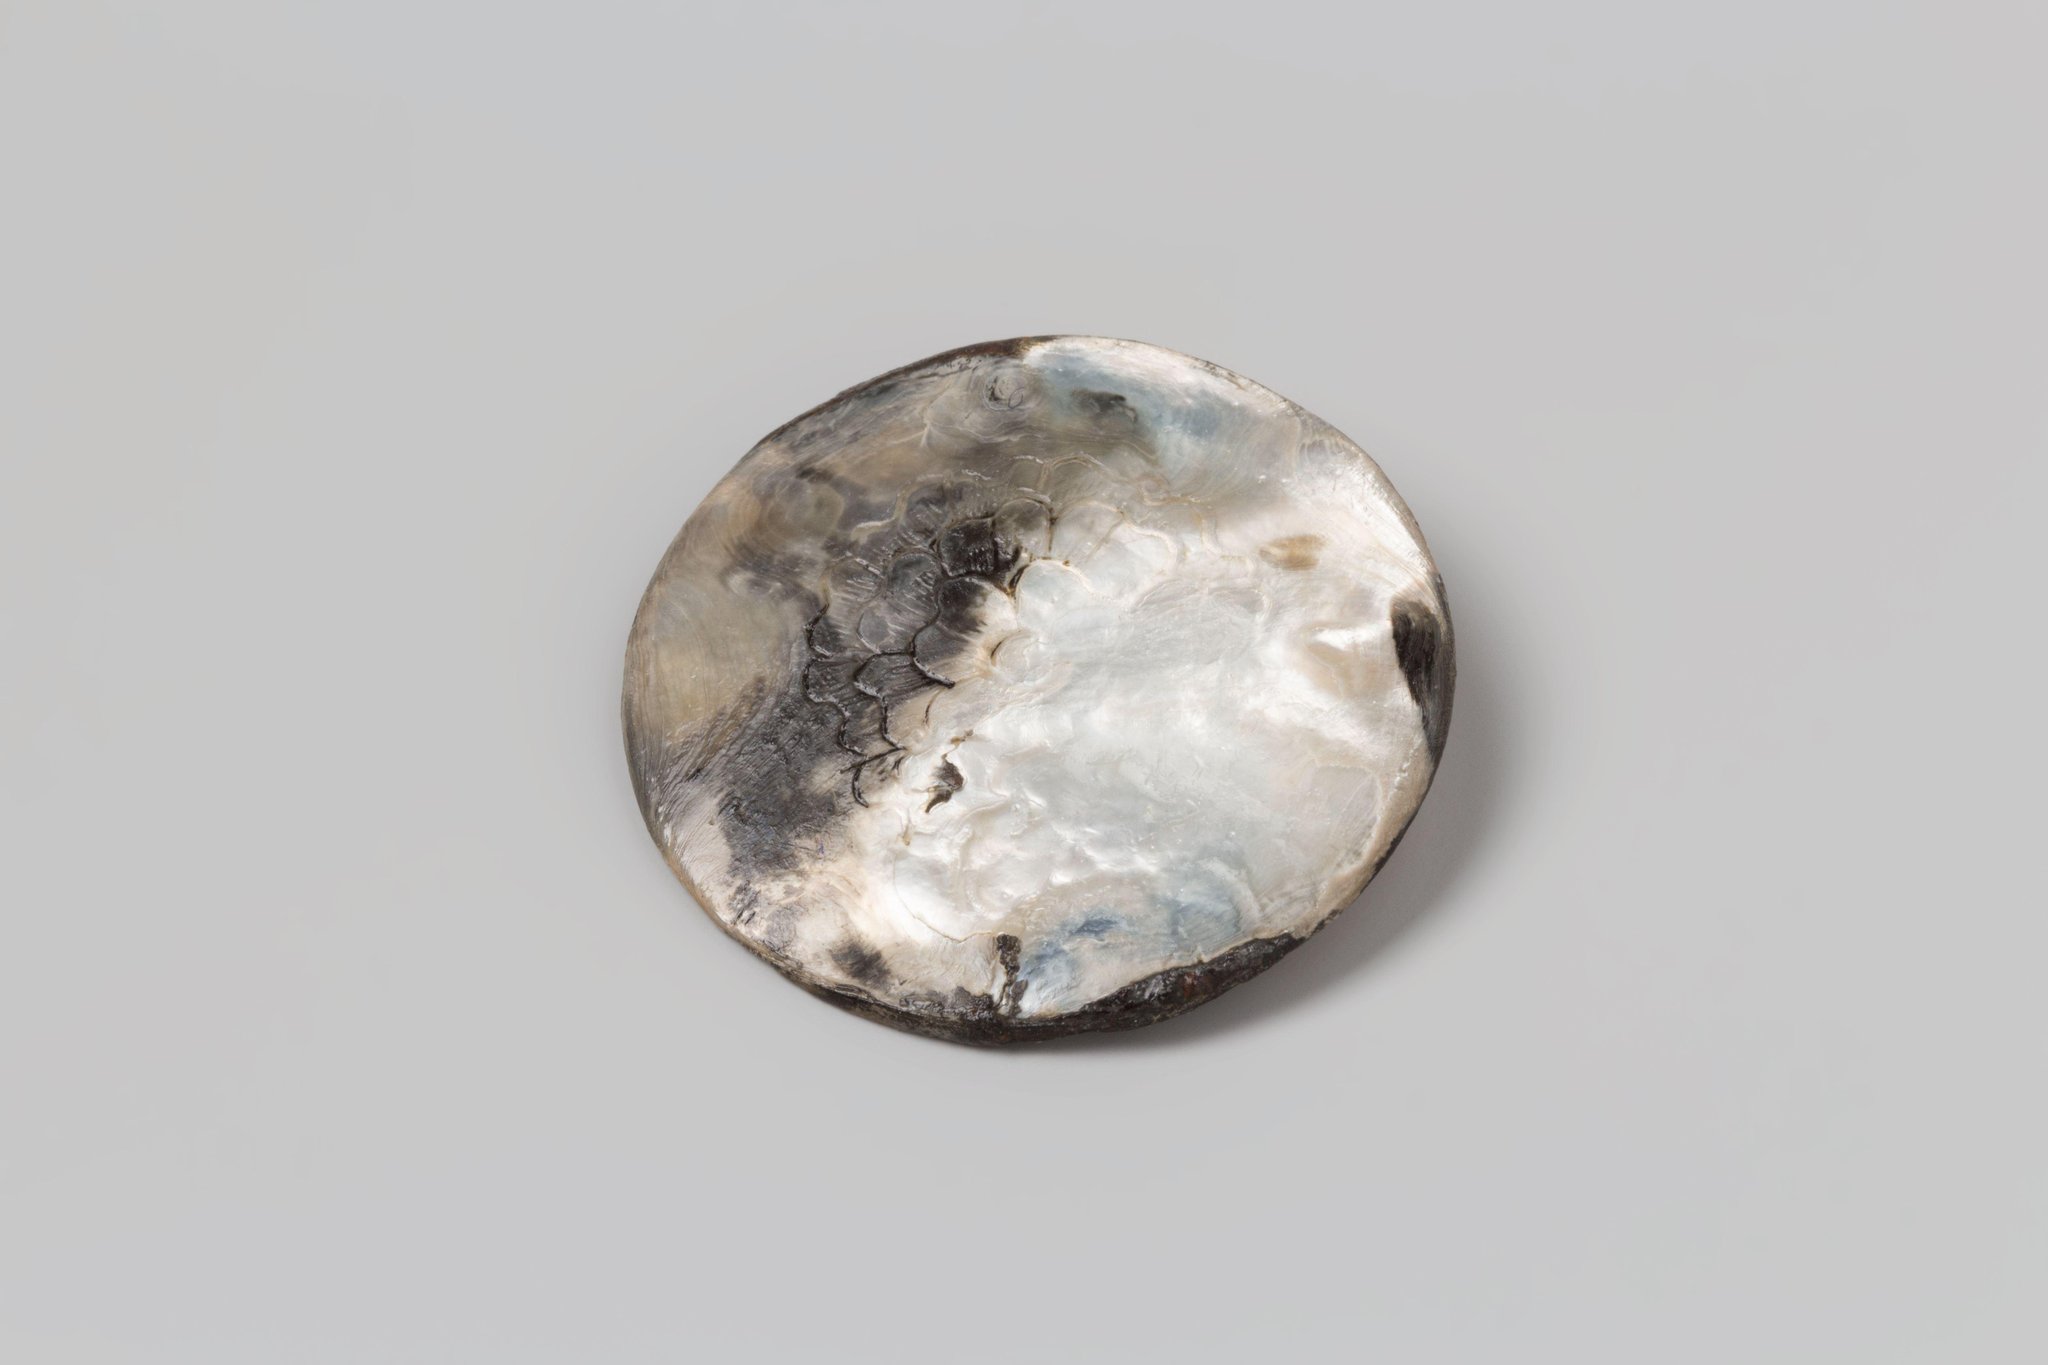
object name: button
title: Knoop uit het wrak van de Oost-Indiëvaarder 't Vliegend Hart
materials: mother of pearl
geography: middelburg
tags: 't vliegend hart (schip), verenigde oostindische compagnie